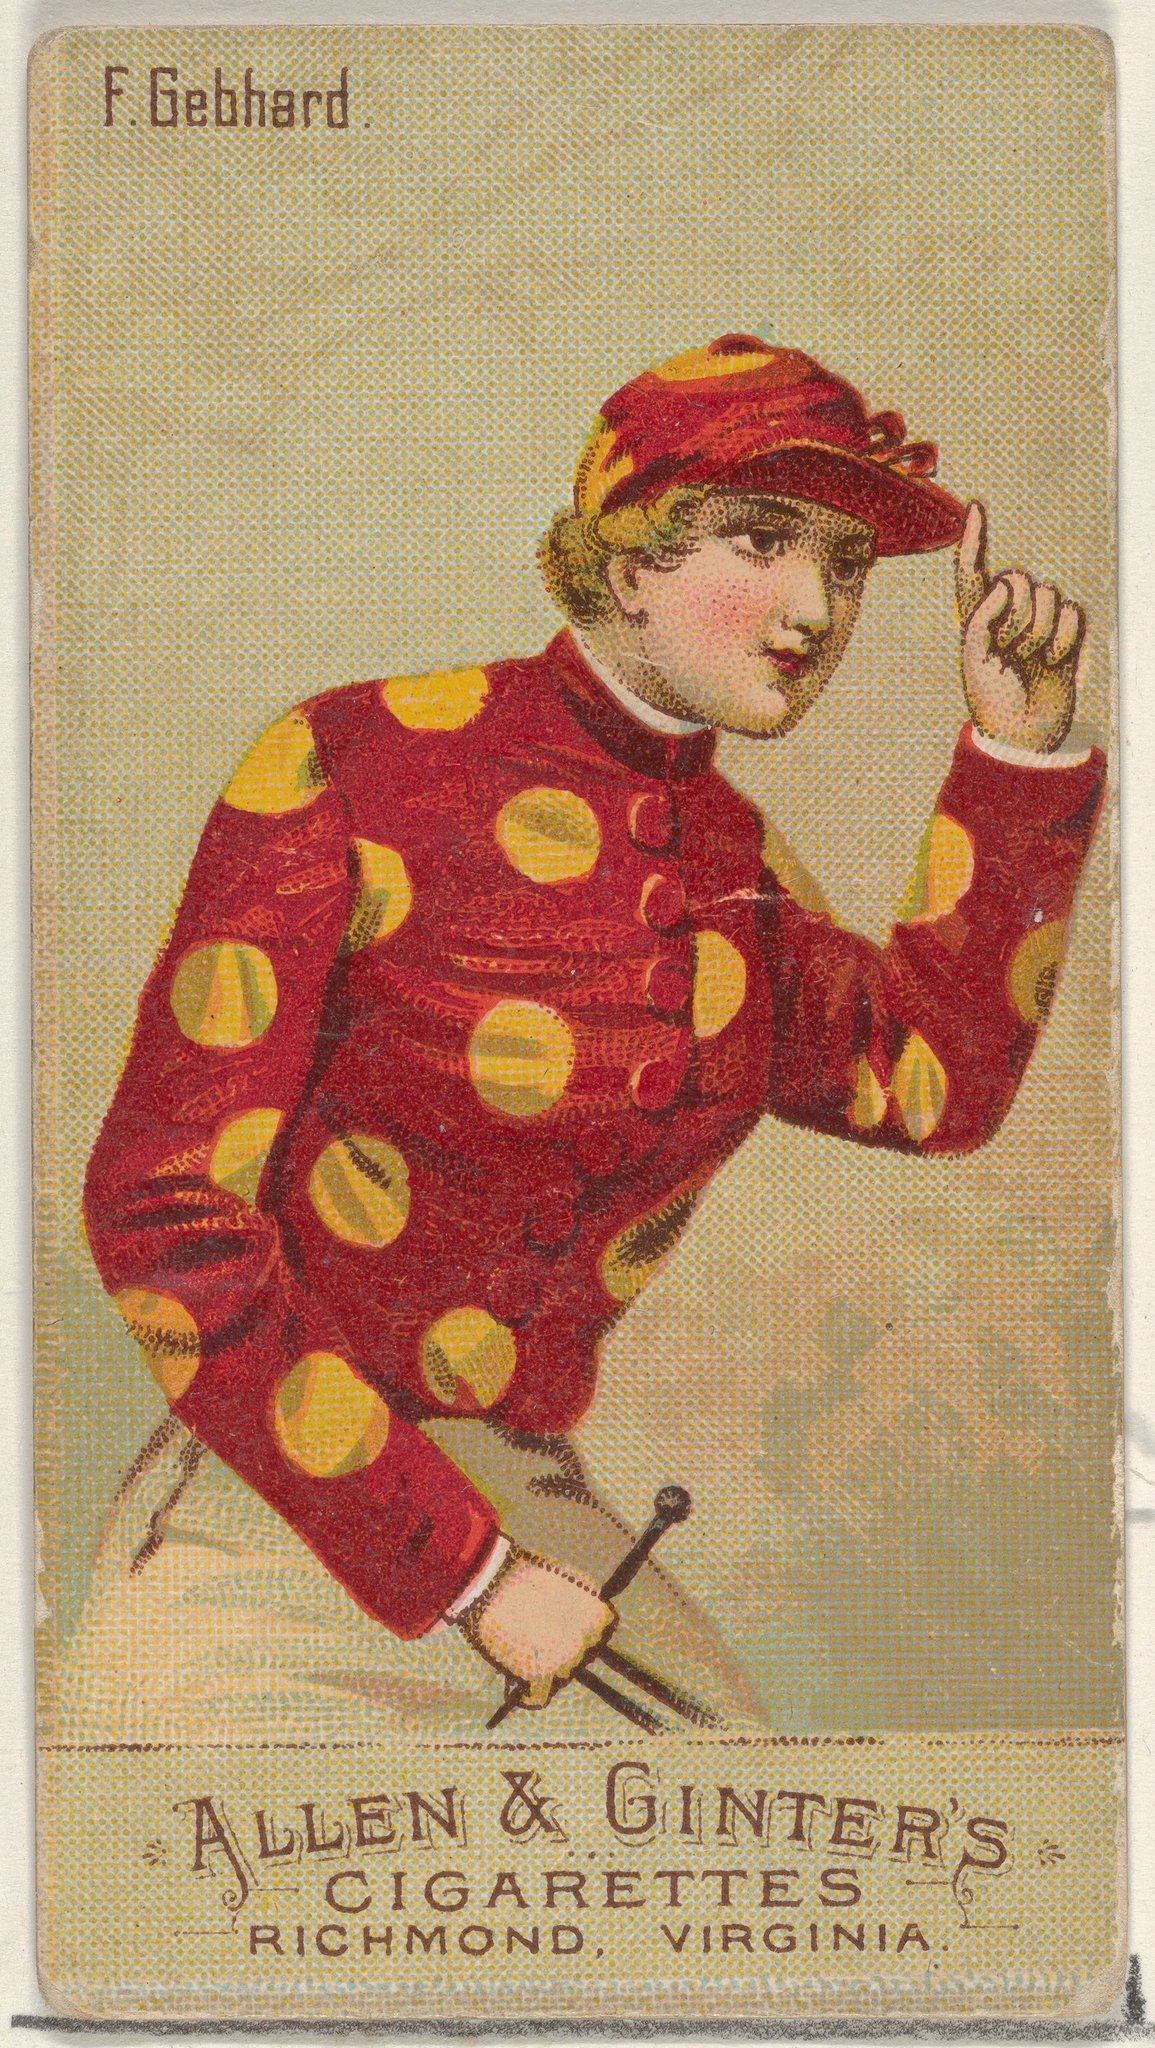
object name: print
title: F. Gebhard, from the Racing Colors of the World series (N22b) for Allen & Ginter Cigarettes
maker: allen & ginter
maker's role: publisher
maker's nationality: american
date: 1888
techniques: color lithograph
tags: women,jockeys